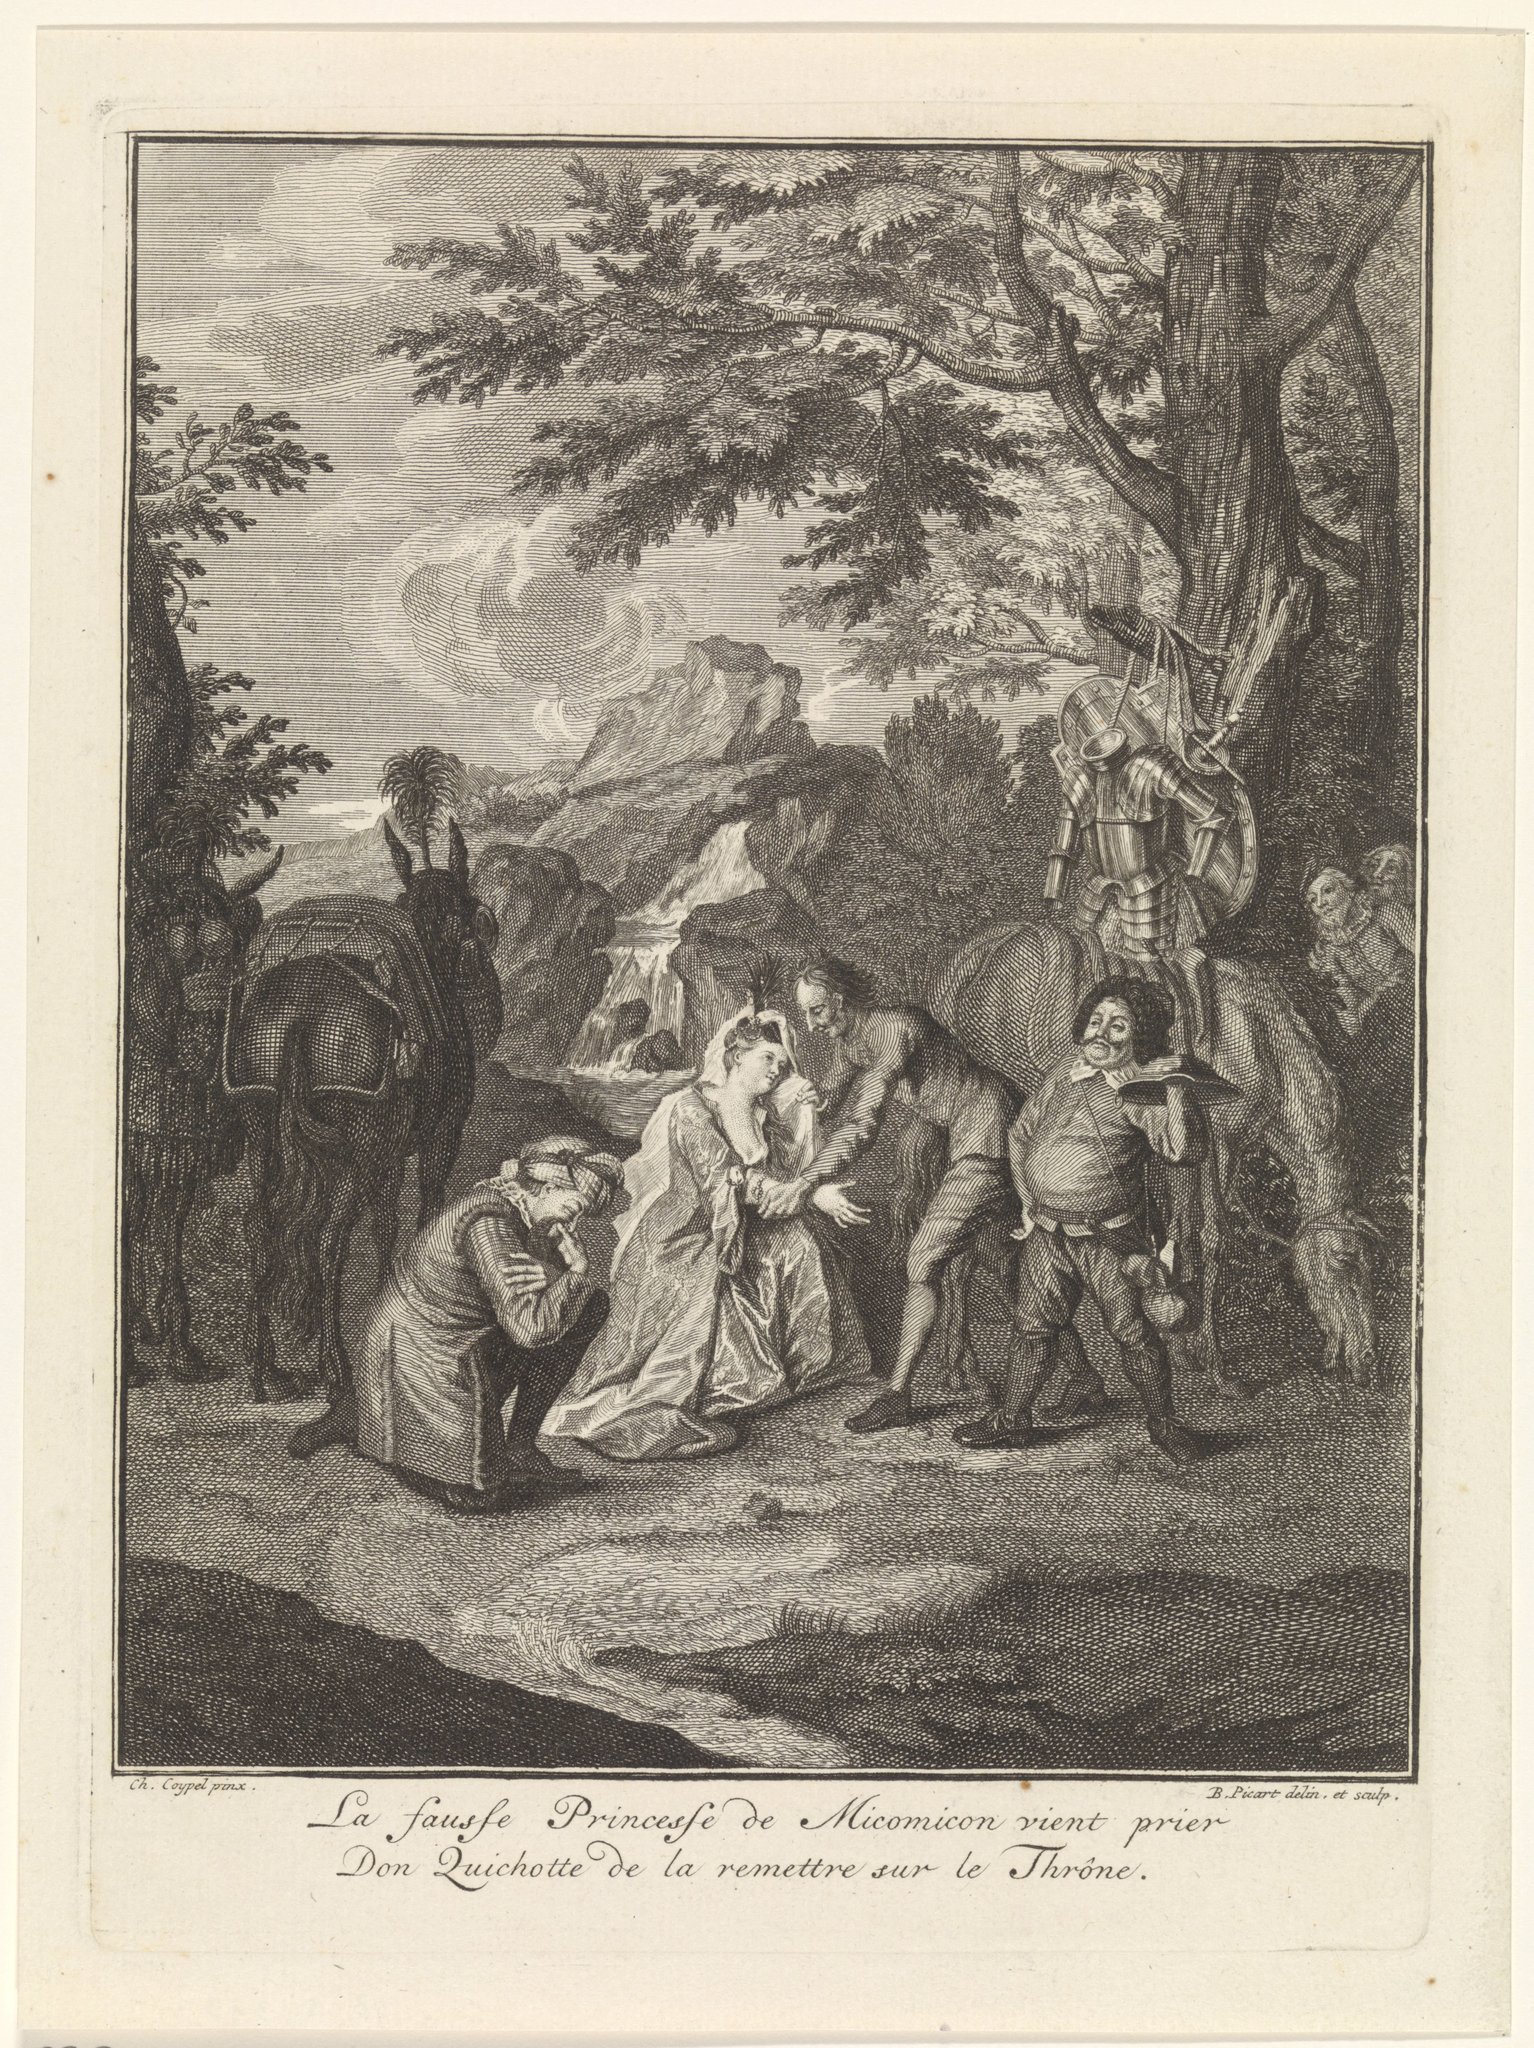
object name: print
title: Prinses van Micomicon geknield voor Don Quichot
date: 1732-1733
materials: paper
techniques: engraving, etching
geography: amsterdam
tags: sancho panza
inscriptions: collector's mark: Lugt 2228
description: Prent ook gebruikt als illustratie in: Cervantes y Saavedra, Miguel de. Les principales avantures de l'admirable Don Quichotte, repréntées en figures (...) avec les explications des XXXI planches (...) tirées de l'original espagnol de Miguel de Cervantes, tussen p. 60 en 61. [Vertaald uit het Spaans door] Jacob Campo Weyerman. Den Haag: Pieter de Hondt, 1746.